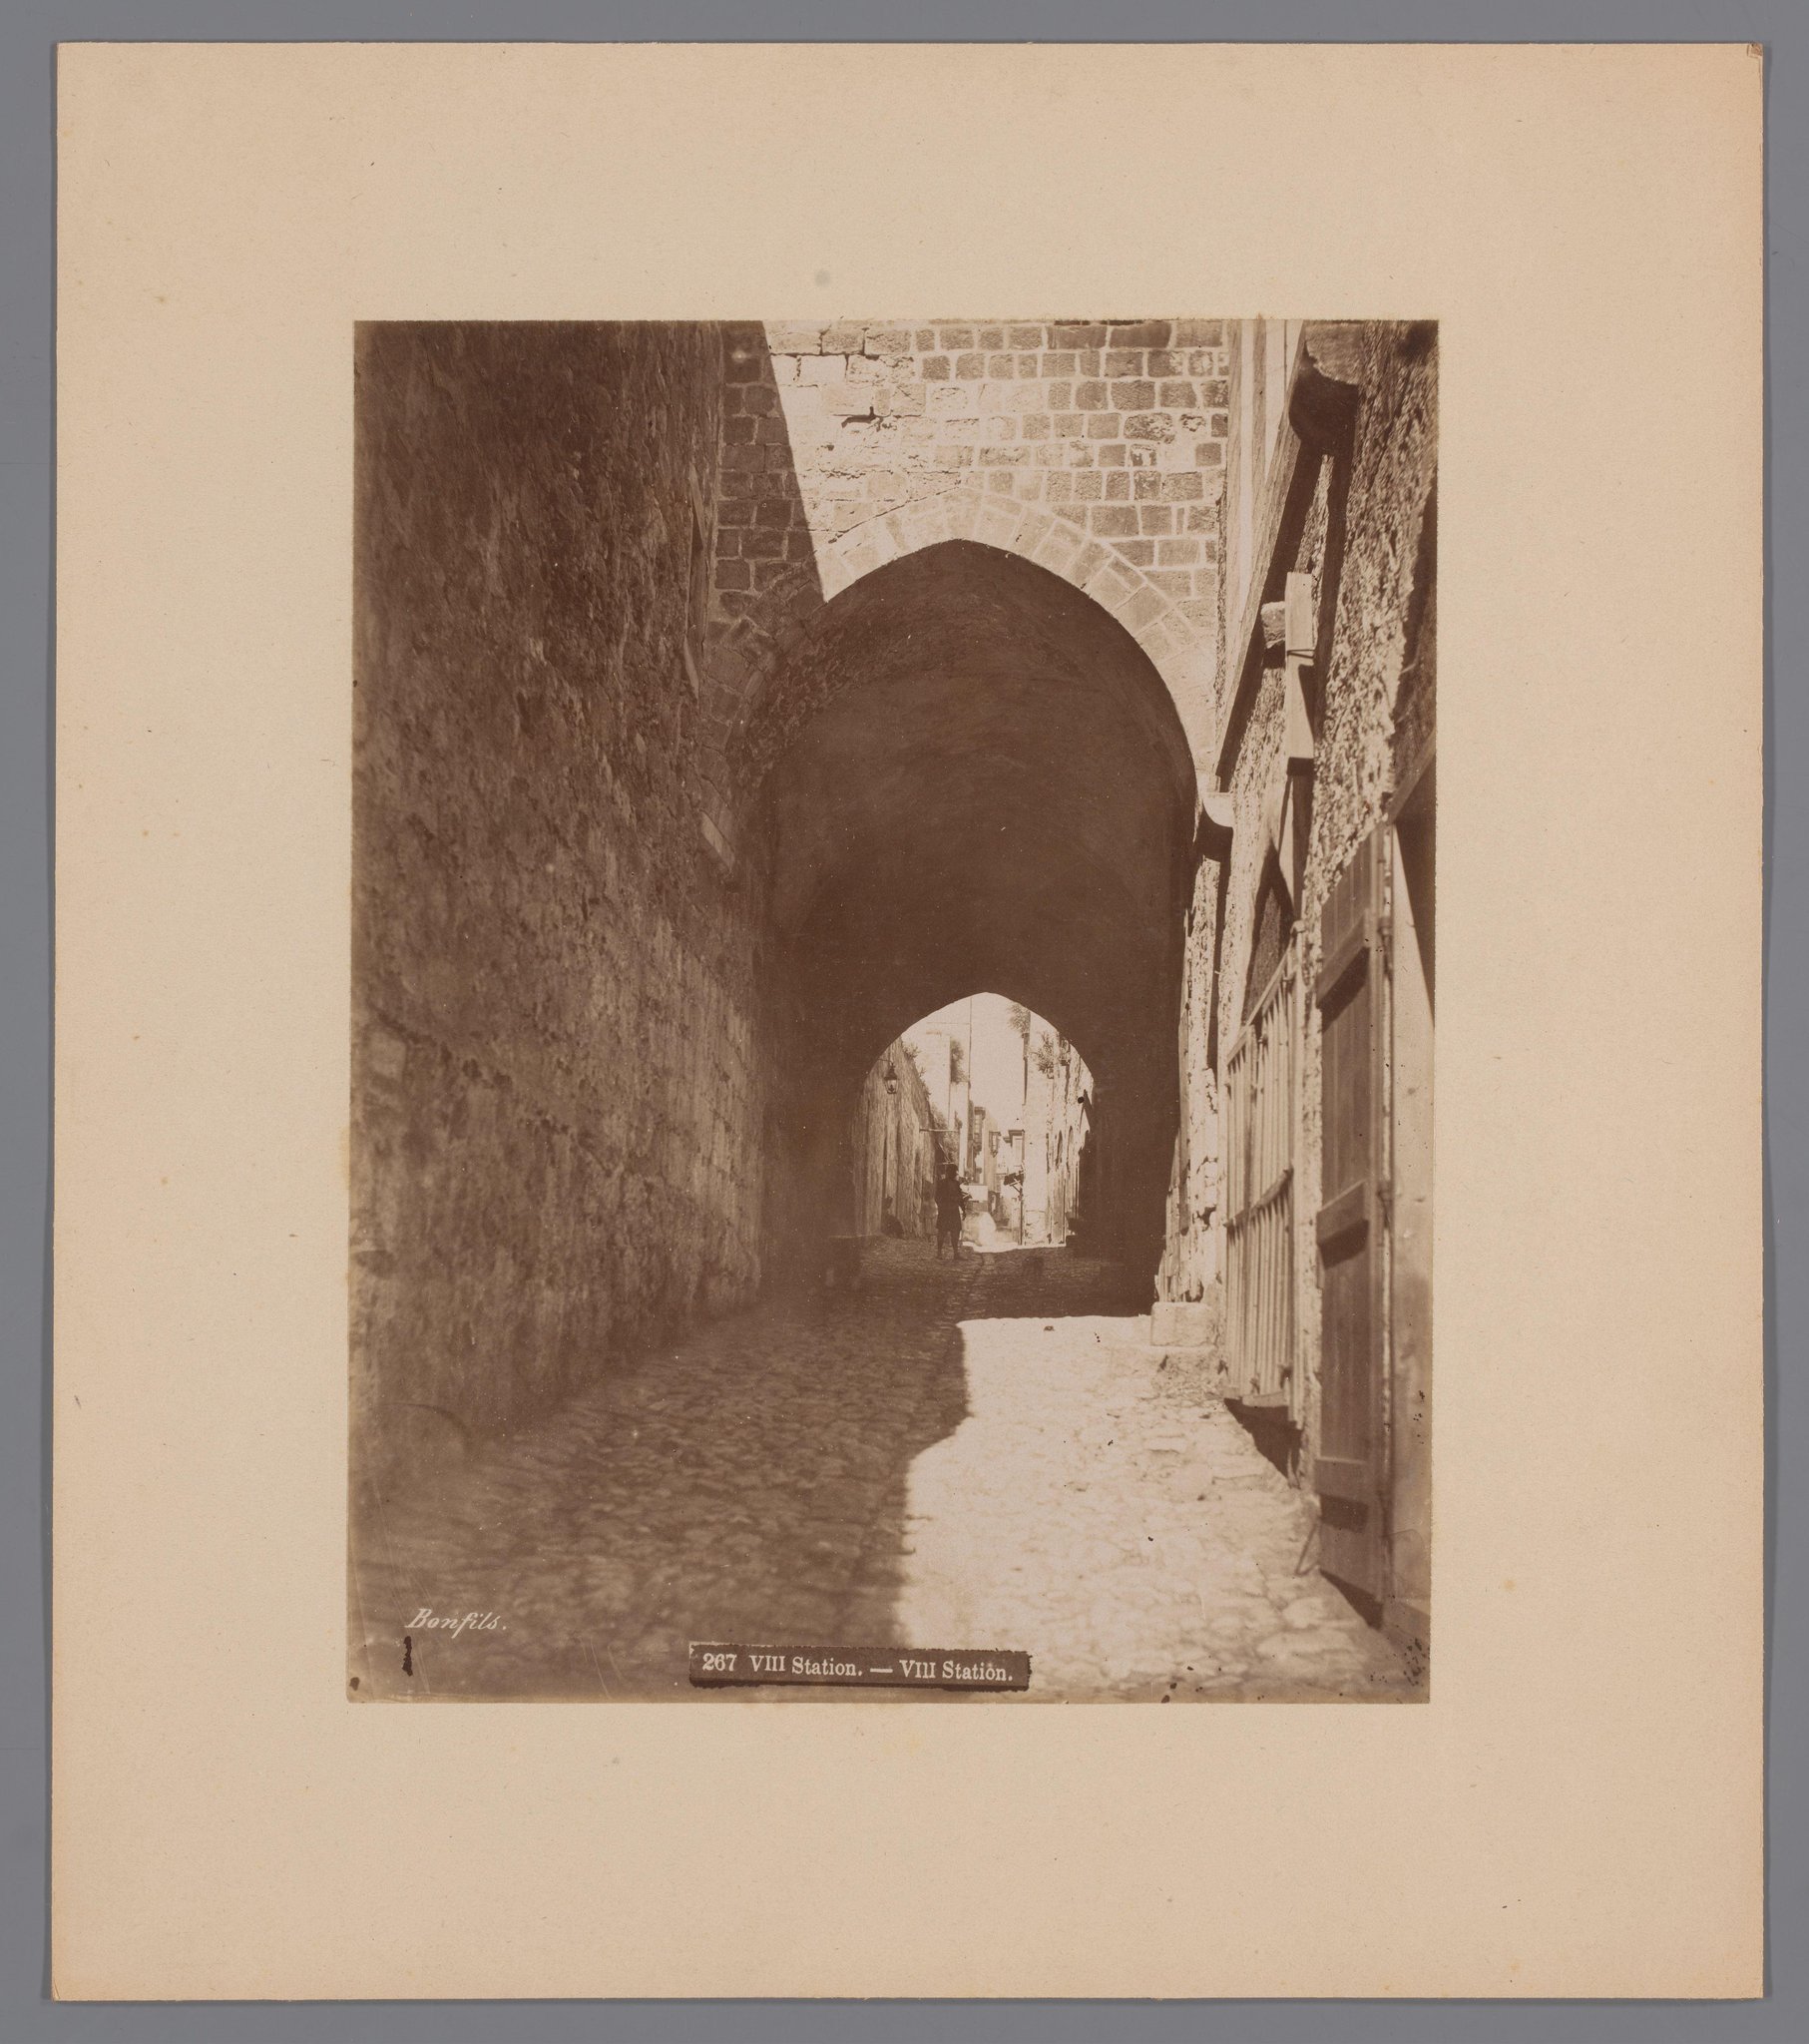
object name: photograph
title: "VIII Station", achtste station in de lijdensweg van Christus [?], Jeruzalem [?], Palestina [?]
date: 1880-1900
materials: cardboard, paper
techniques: albumen print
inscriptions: inscription: ‘267 VIII Station. - VIII Station.’, signature: ‘Bonfils’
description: Aanzicht op een poort, Jeruzalem [?], Palestina [?]